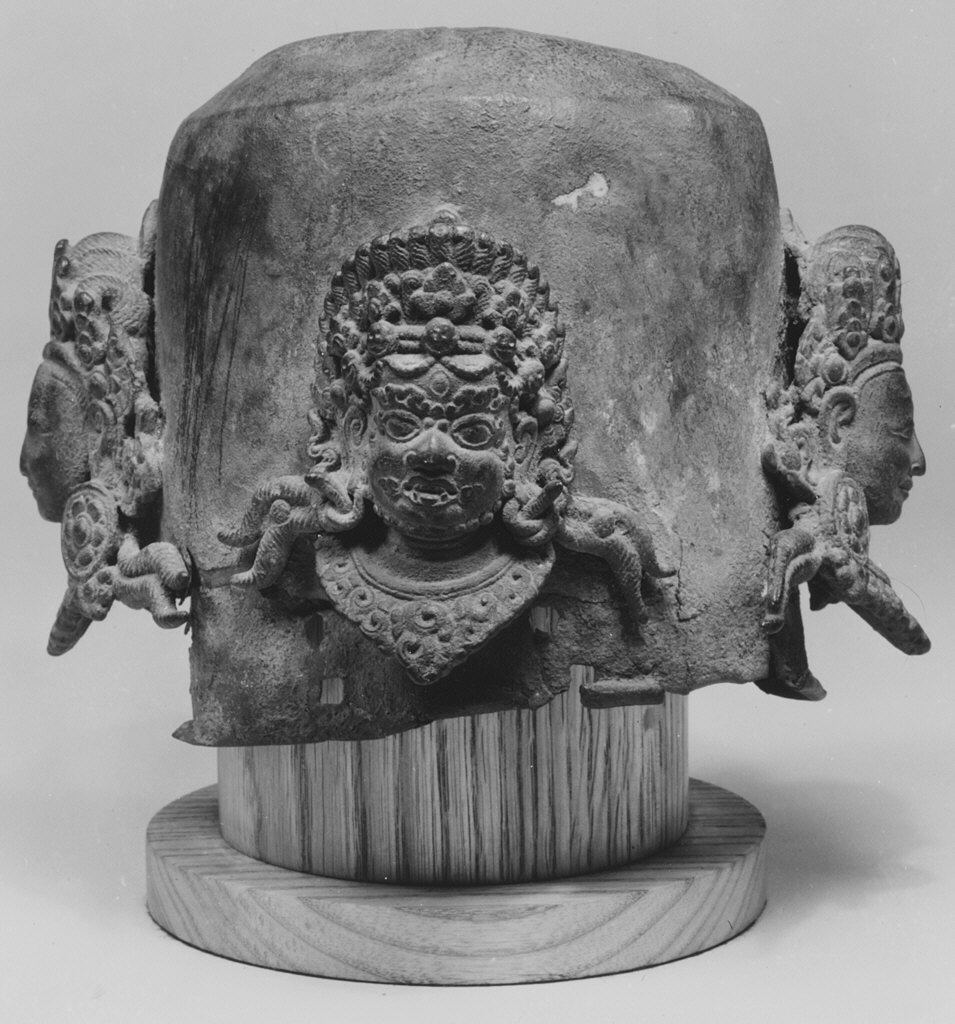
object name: linga cover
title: Linga Cover with Four Faces of Shiva (Caturmukhalinga)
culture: nepali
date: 1401-1500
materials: copper alloy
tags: faces,shiva,hinduism